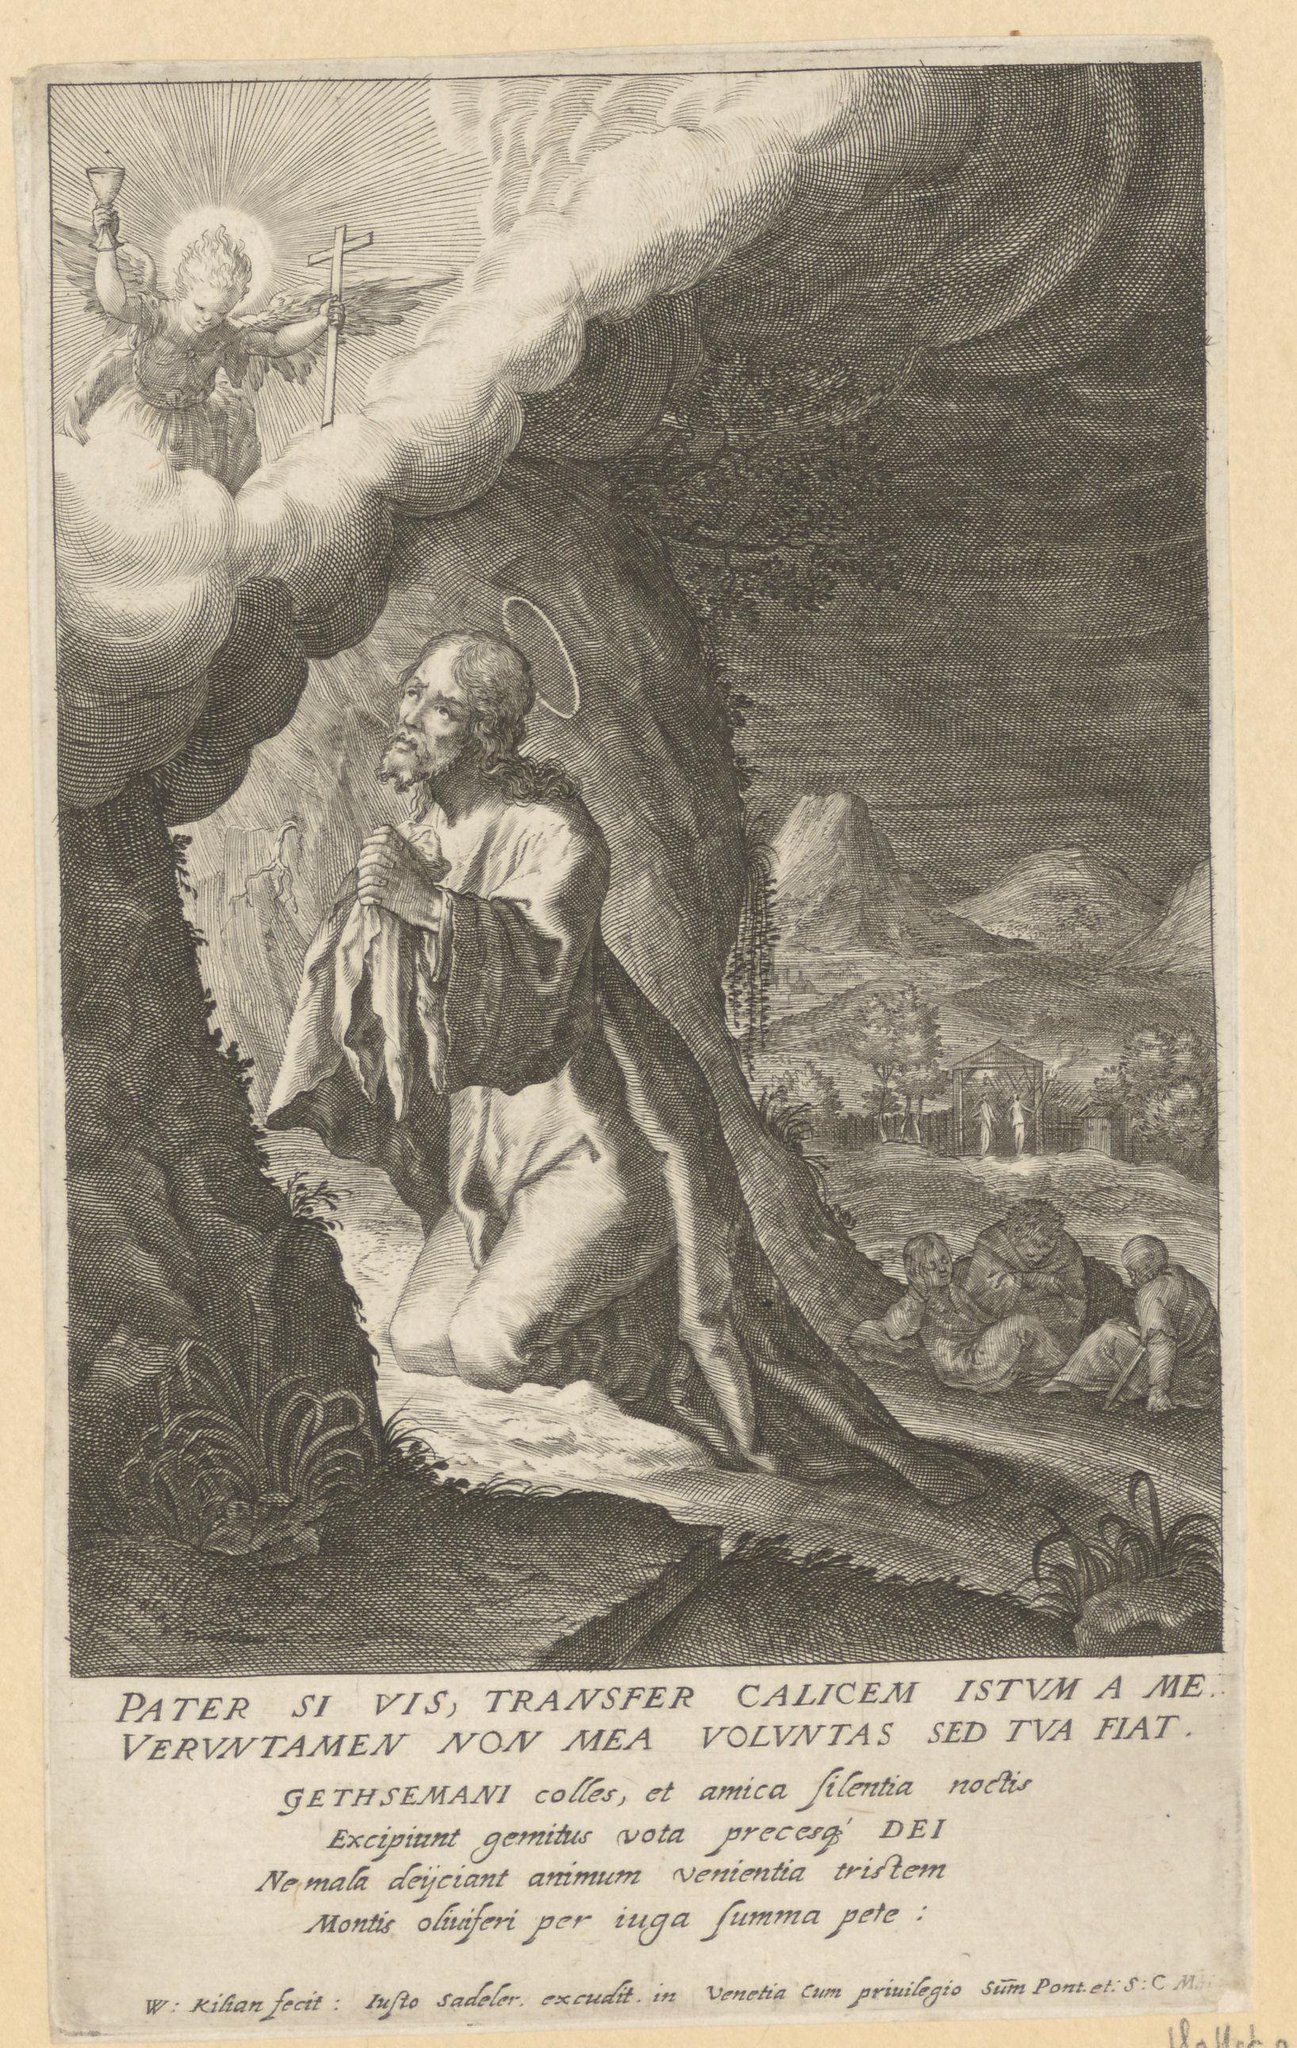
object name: print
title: Christus biddend in Gethsemane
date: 1591-1620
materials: paper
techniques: engraving, etching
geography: venice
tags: christ's prayer in the garden of gethsemane during the night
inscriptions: collector's mark: Lugt 2228